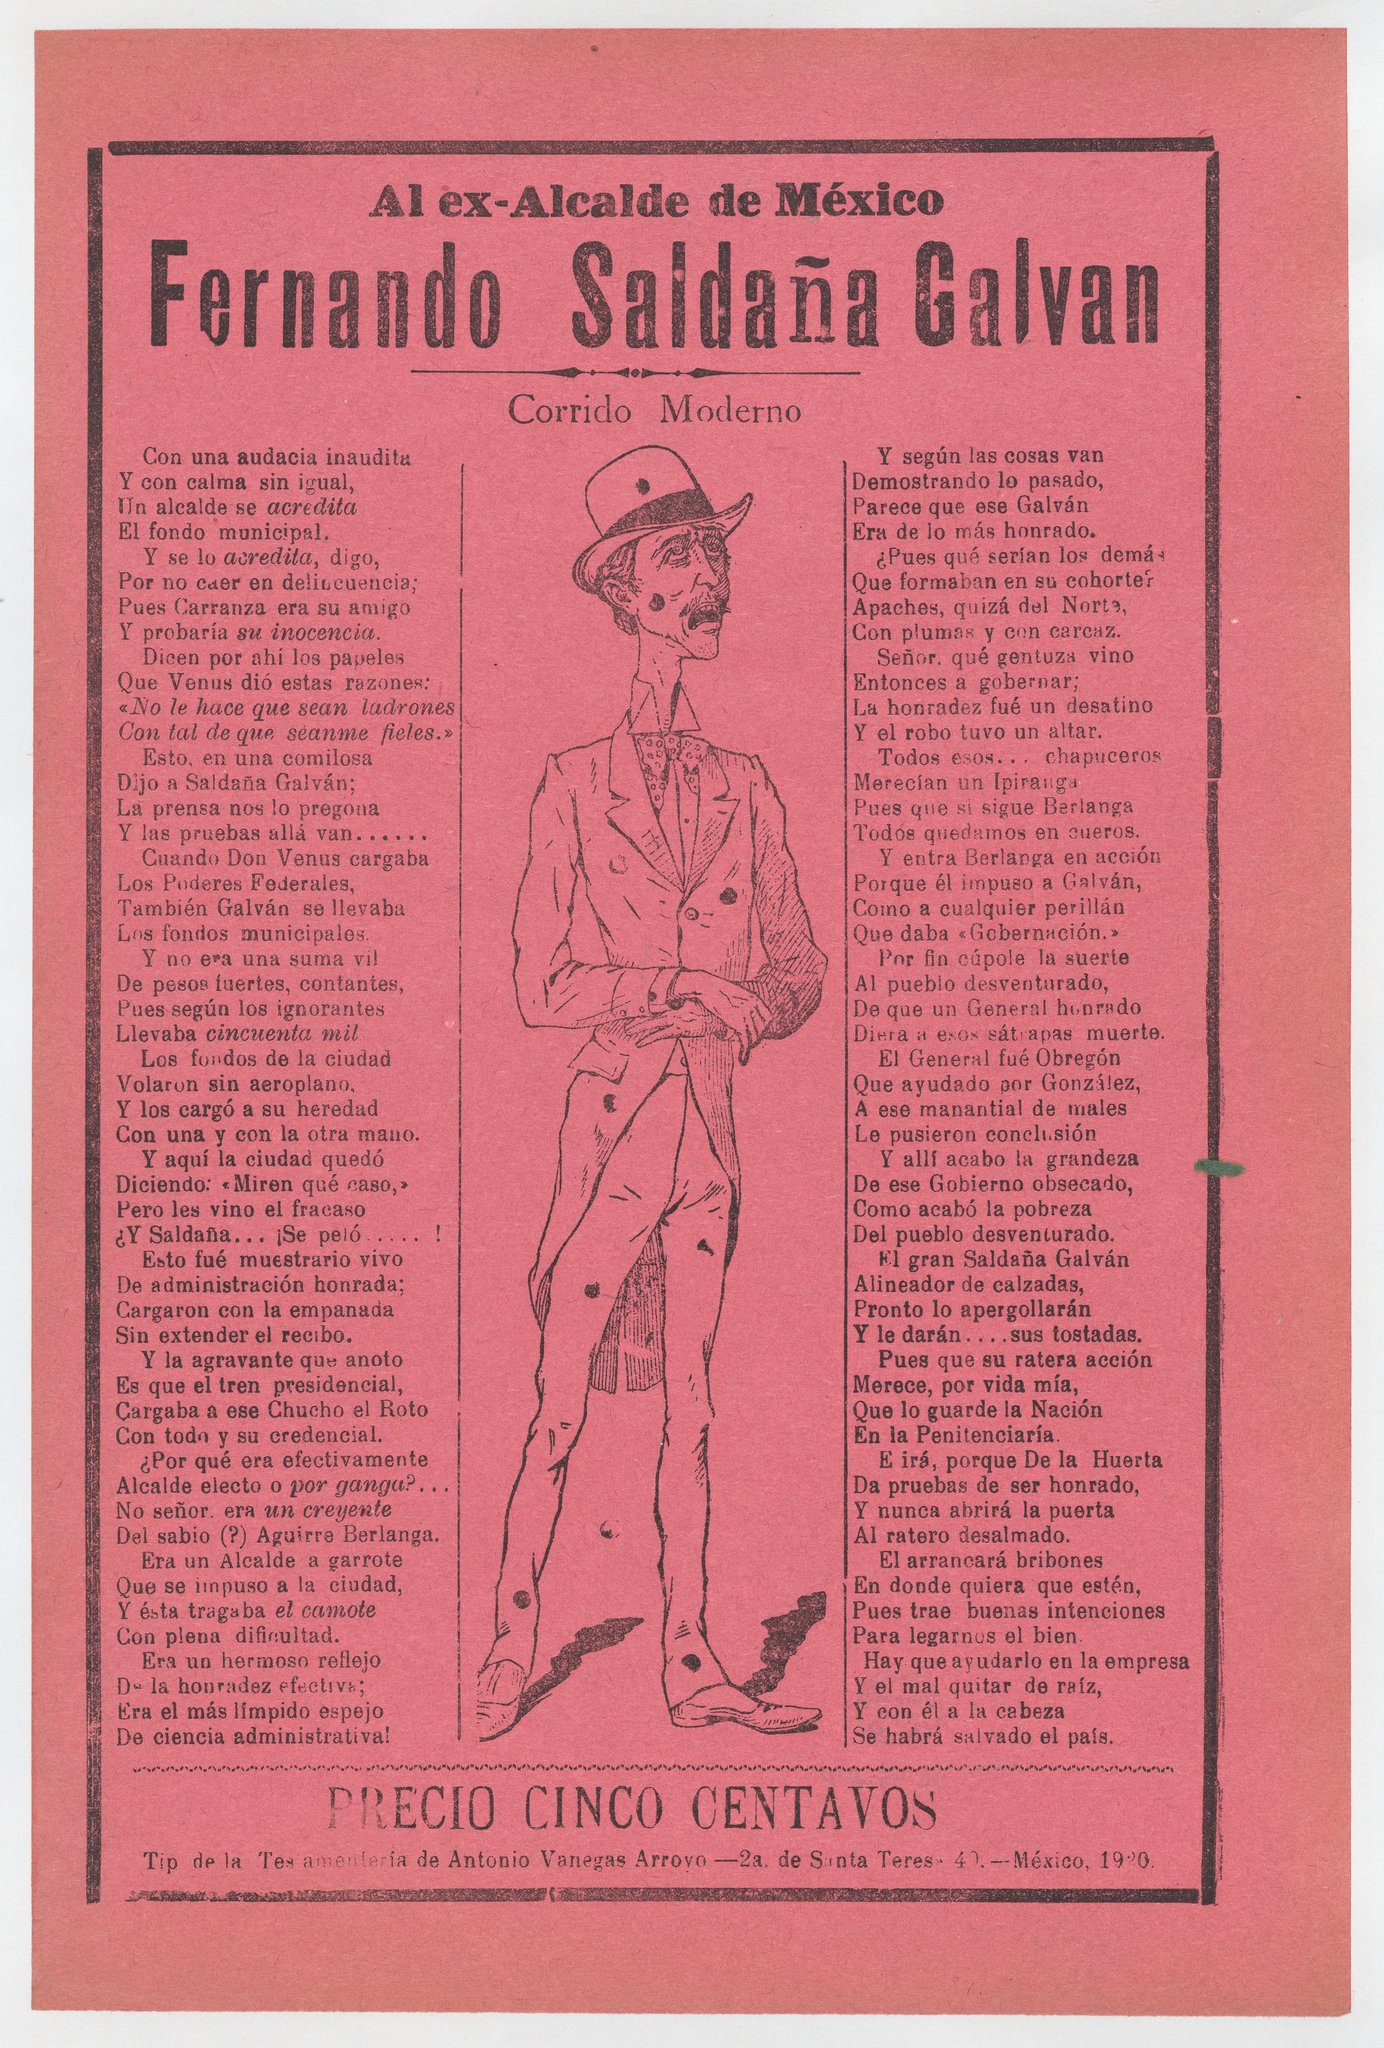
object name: print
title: Broadsheet relating to the ex mayor of Mexico, Fernando Saldaña Galvan, who is standing in the center covered in holes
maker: josé guadalupe posada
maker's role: artist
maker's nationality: mexican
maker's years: 1852-1913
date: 1920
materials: paper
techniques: letterpress, lithography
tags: men